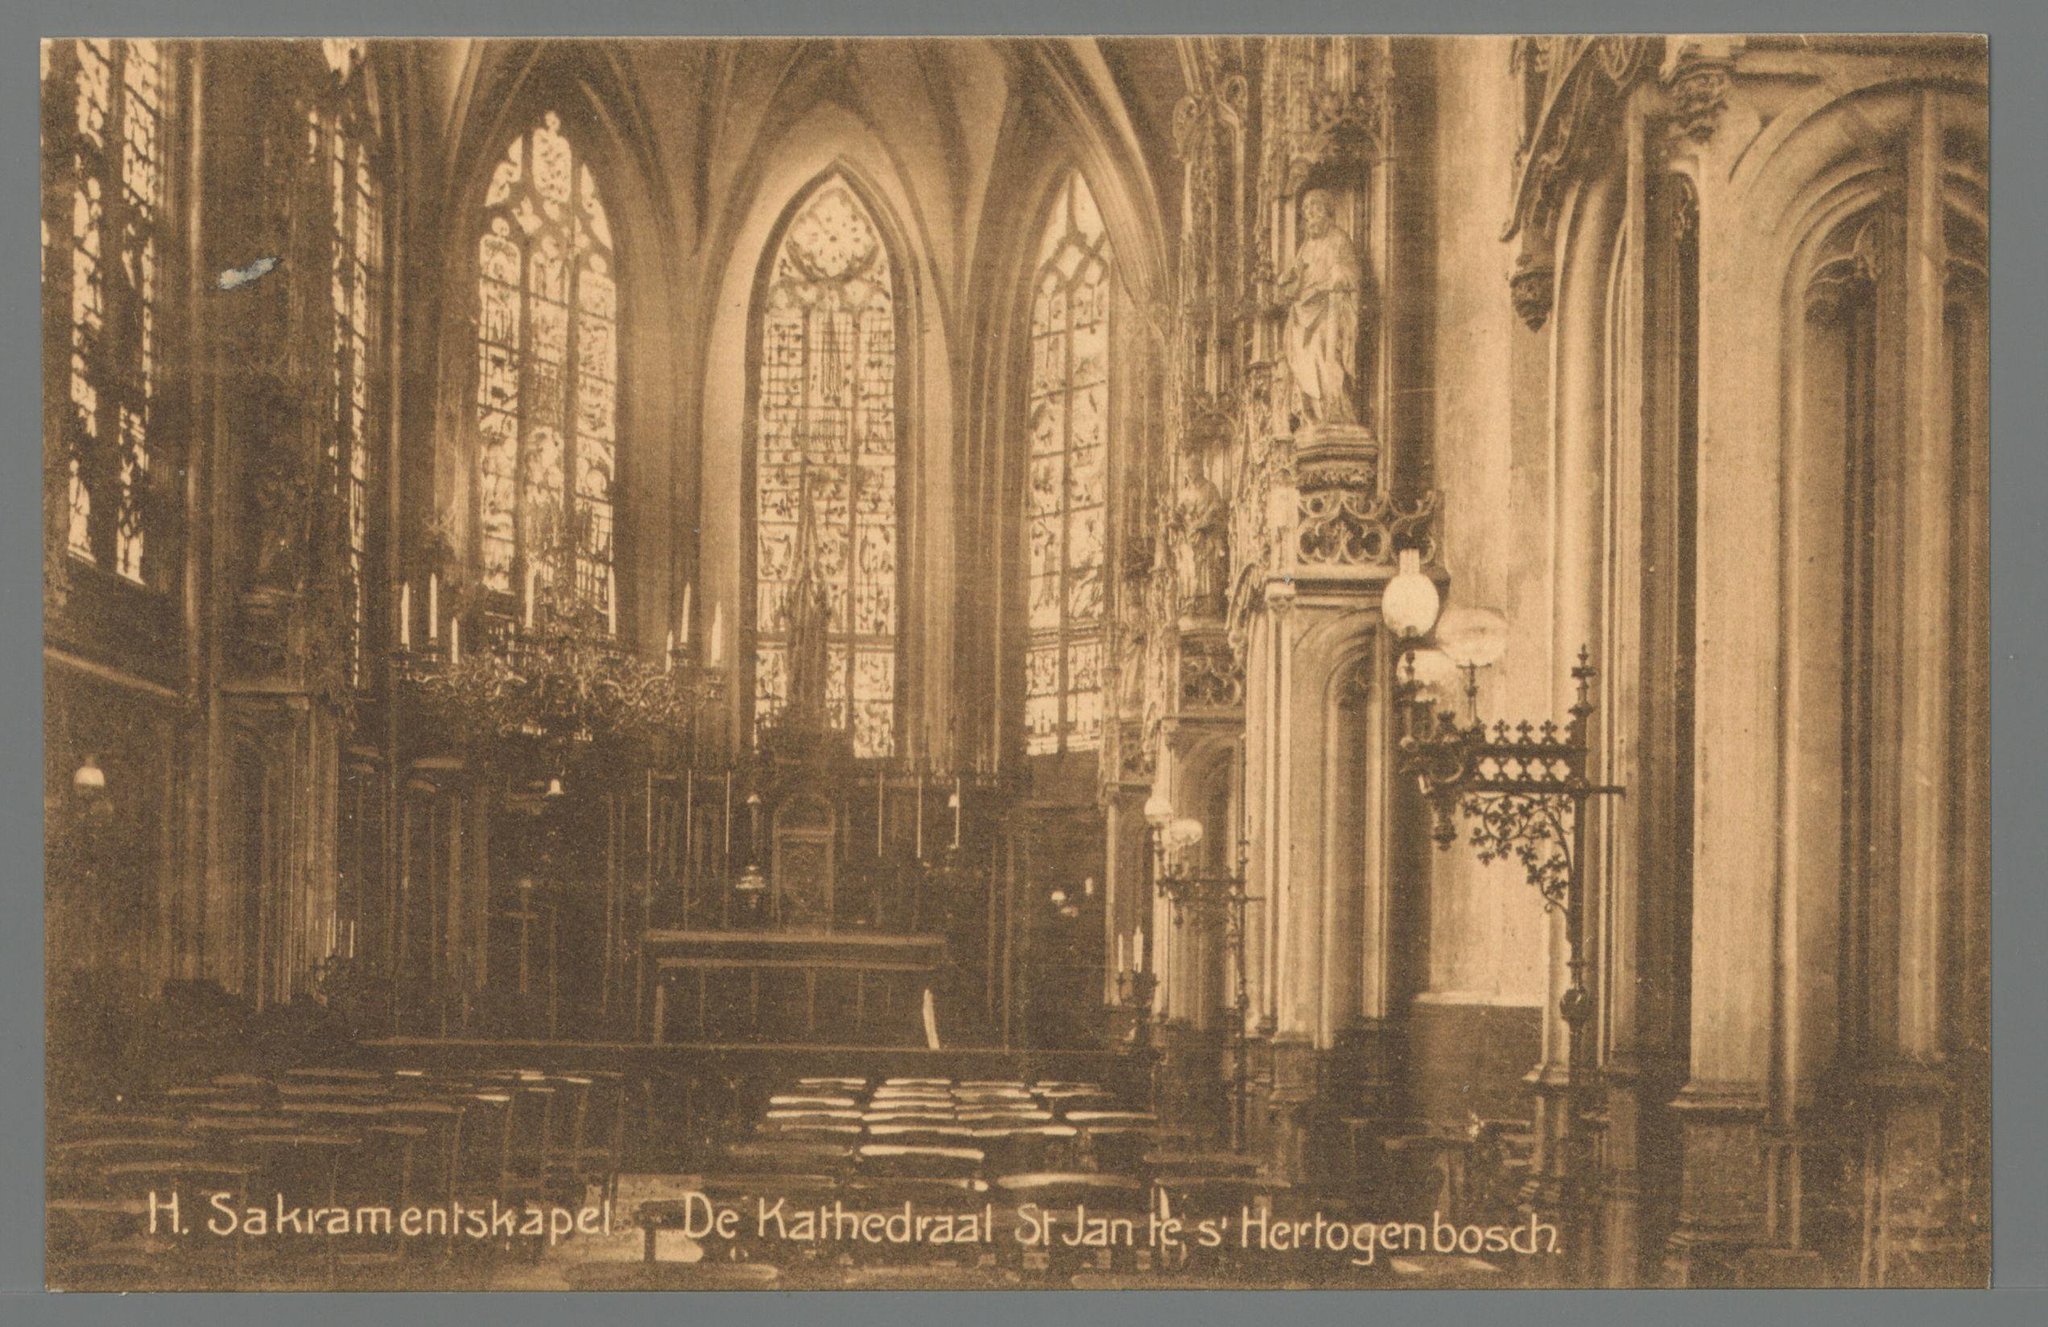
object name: ansichtkaart, prentbriefkaart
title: De Kathedraal St Jan te s' Hertogenbosch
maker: Anonymous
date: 1905-1930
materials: cardboard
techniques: photograph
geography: den bosch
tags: parts of church interior: chapel